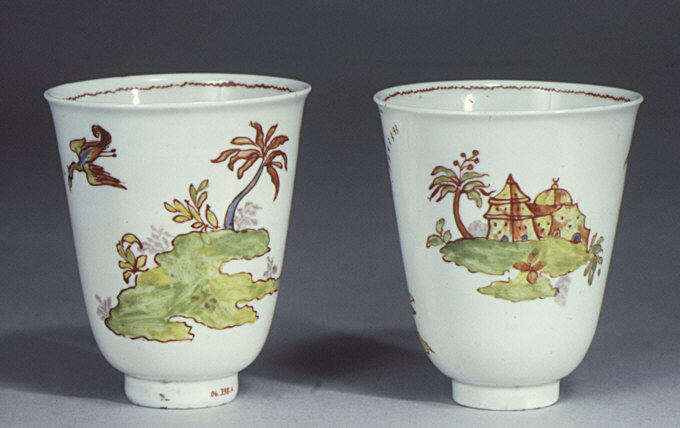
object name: beaker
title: Beakers (2)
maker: vezzi factory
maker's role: factory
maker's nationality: italian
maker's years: 1720-1727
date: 1720-1727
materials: hard paste porcelain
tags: birds,buildings,trees